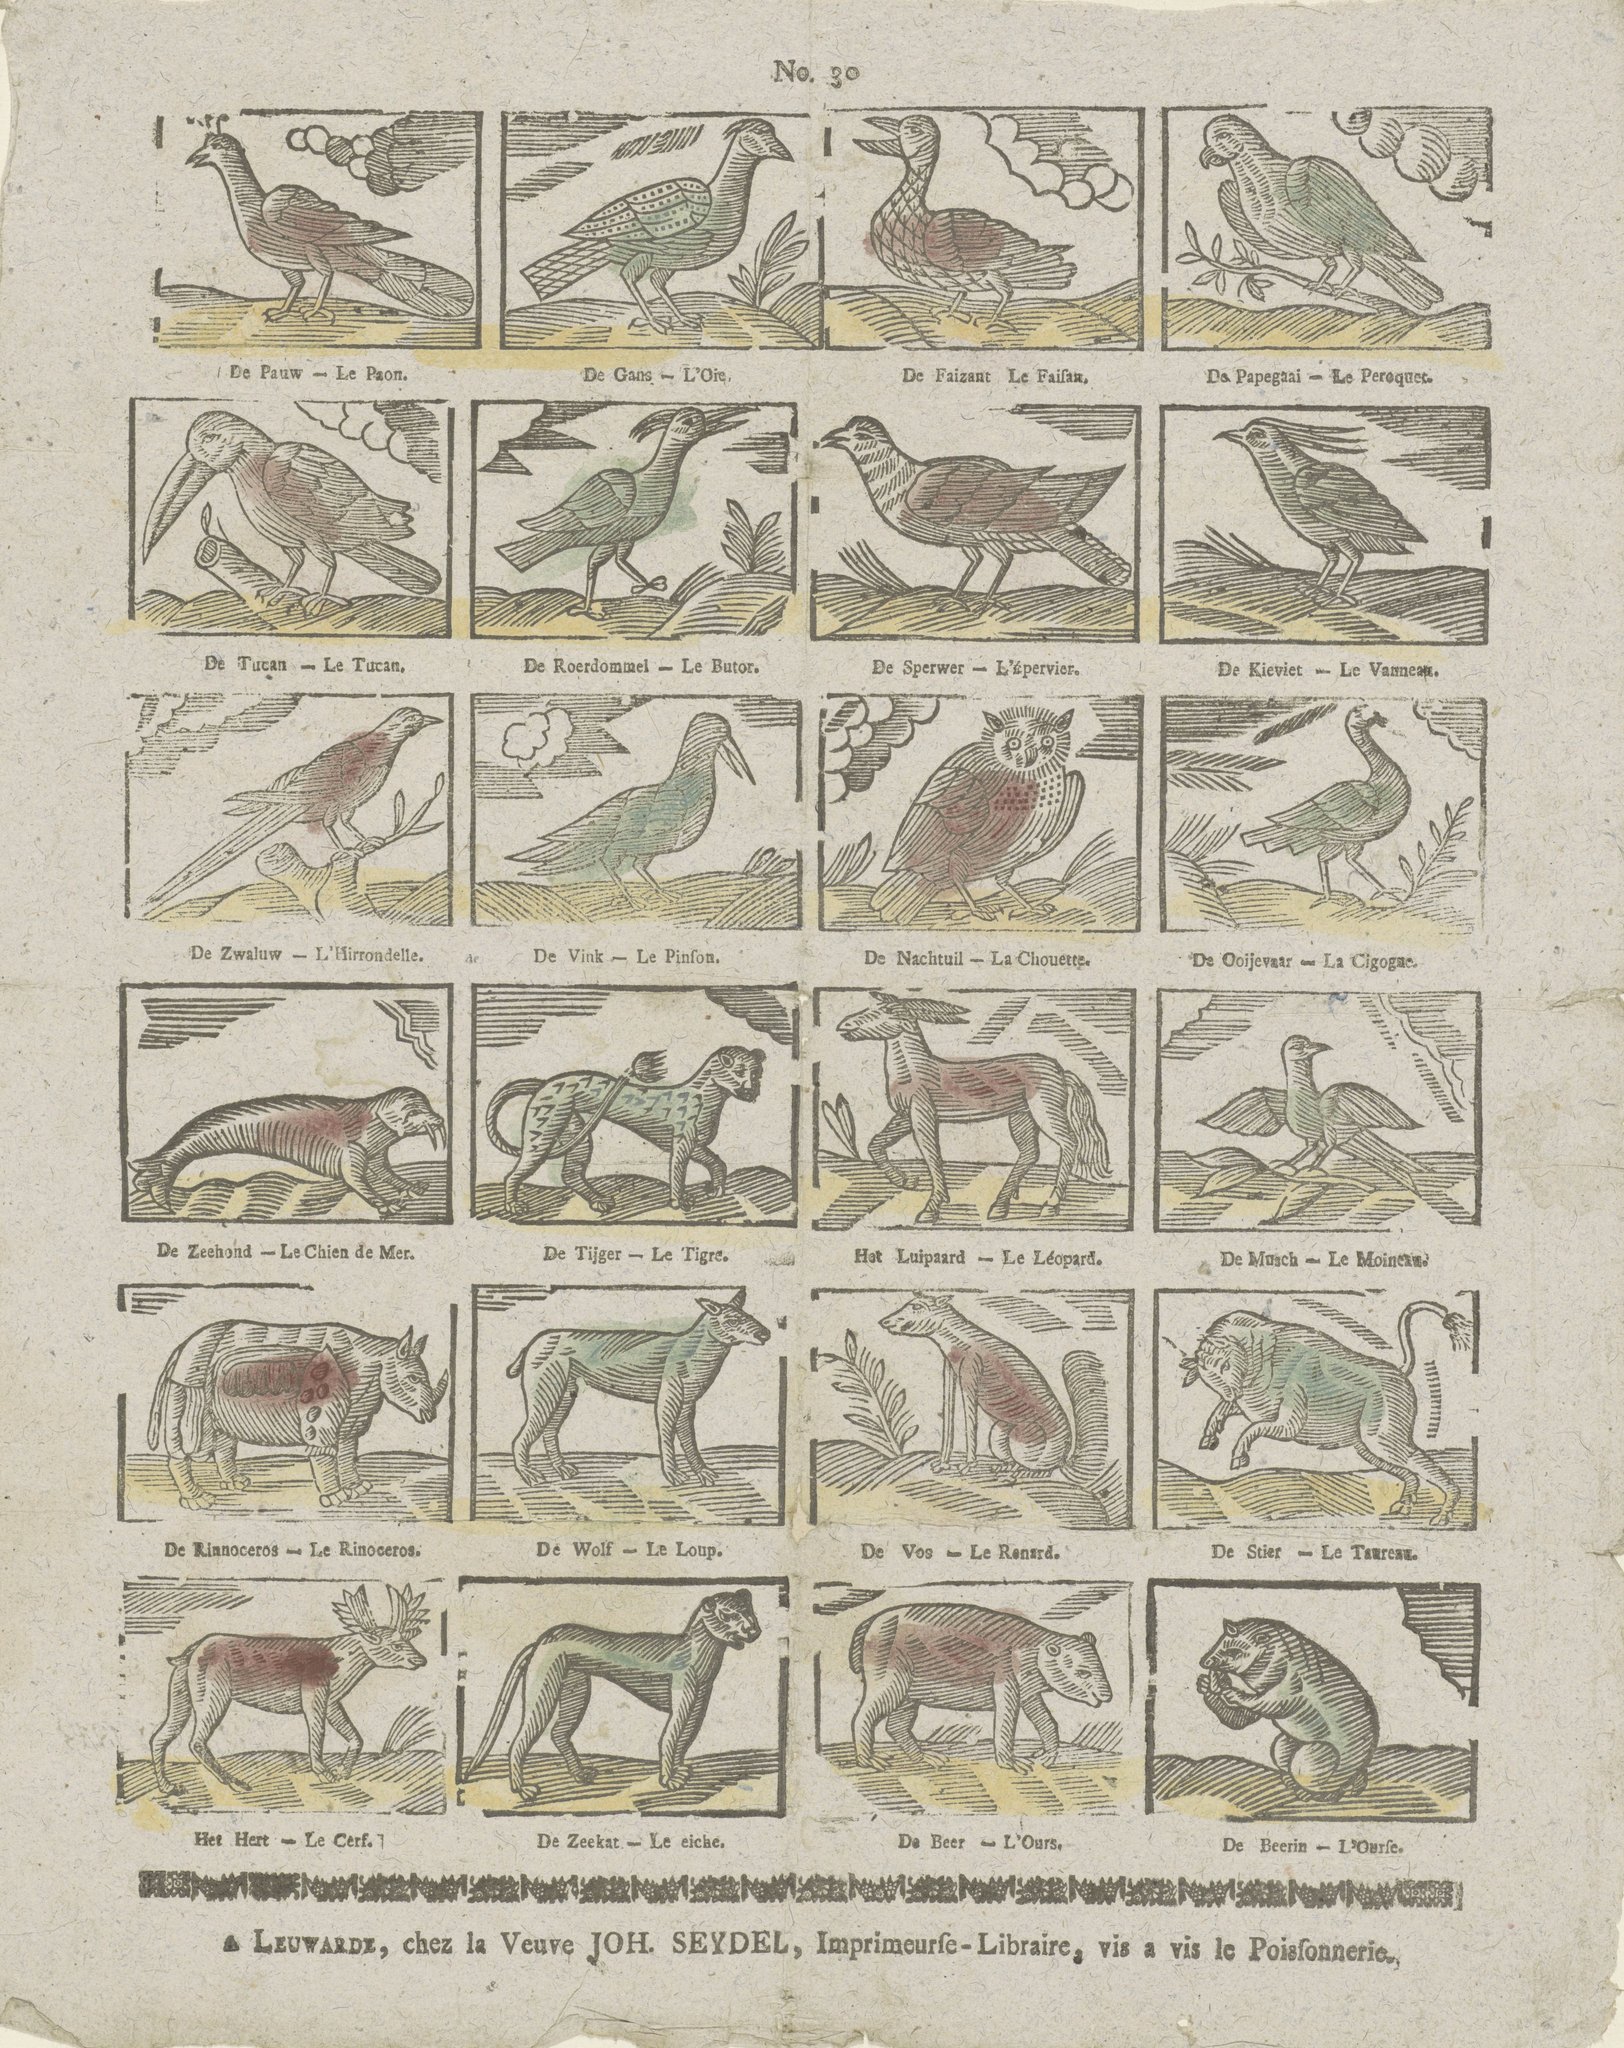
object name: popular print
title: Dieren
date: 1776-1813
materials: paper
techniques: colour, letterpress printing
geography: leeuwarden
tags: animals, birds, hoofed animals: rhinoceros, beasts of prey, predatory animals: bear, owls, swimming mammals: seal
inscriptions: inscription:, collector's mark: Lugt 2166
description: Blad met 24 voorstellingen van dieren, waaronder verschillende vogels, een zeehond, een neushoorn en een beer. Onder elke voorstelling een onderschrift in het Nederlands en in het Frans. Genummerd midden boven: No. 30.